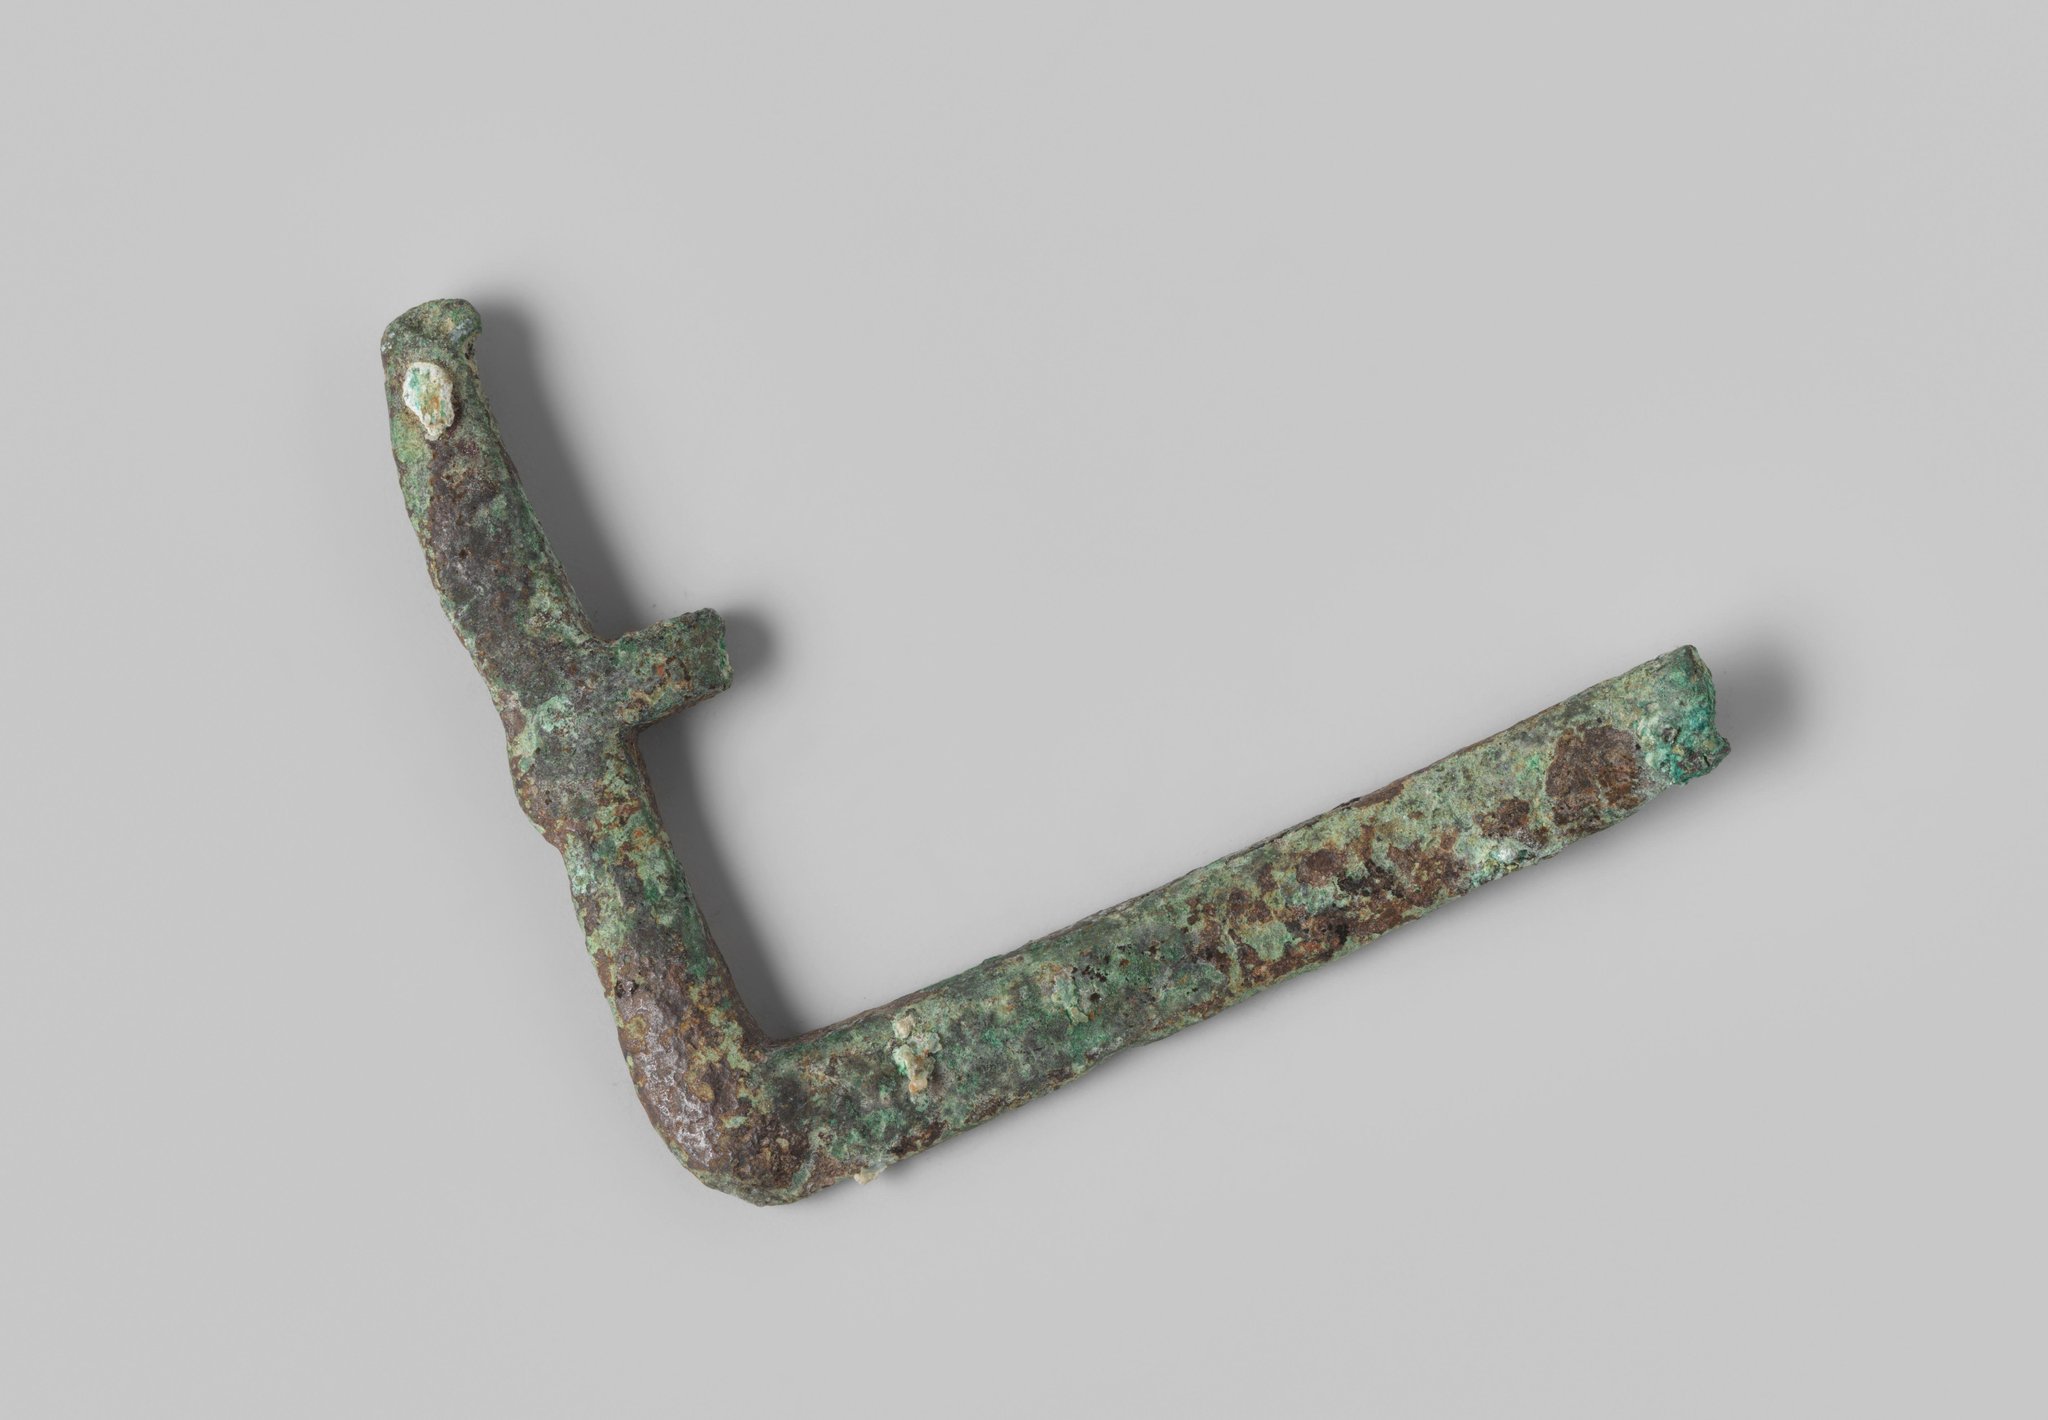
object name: belt buckle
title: Fragment riemgesp uit het wrak van de Oost-Indiëvaarder Hollandia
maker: Anonymous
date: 1700-1743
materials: copper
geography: netherlands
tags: verenigde oostindische compagnie, hollandia (schip), annet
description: Rectangular, fragm of ring with spindle, id. NG 1980-27H2796, belt buckle.